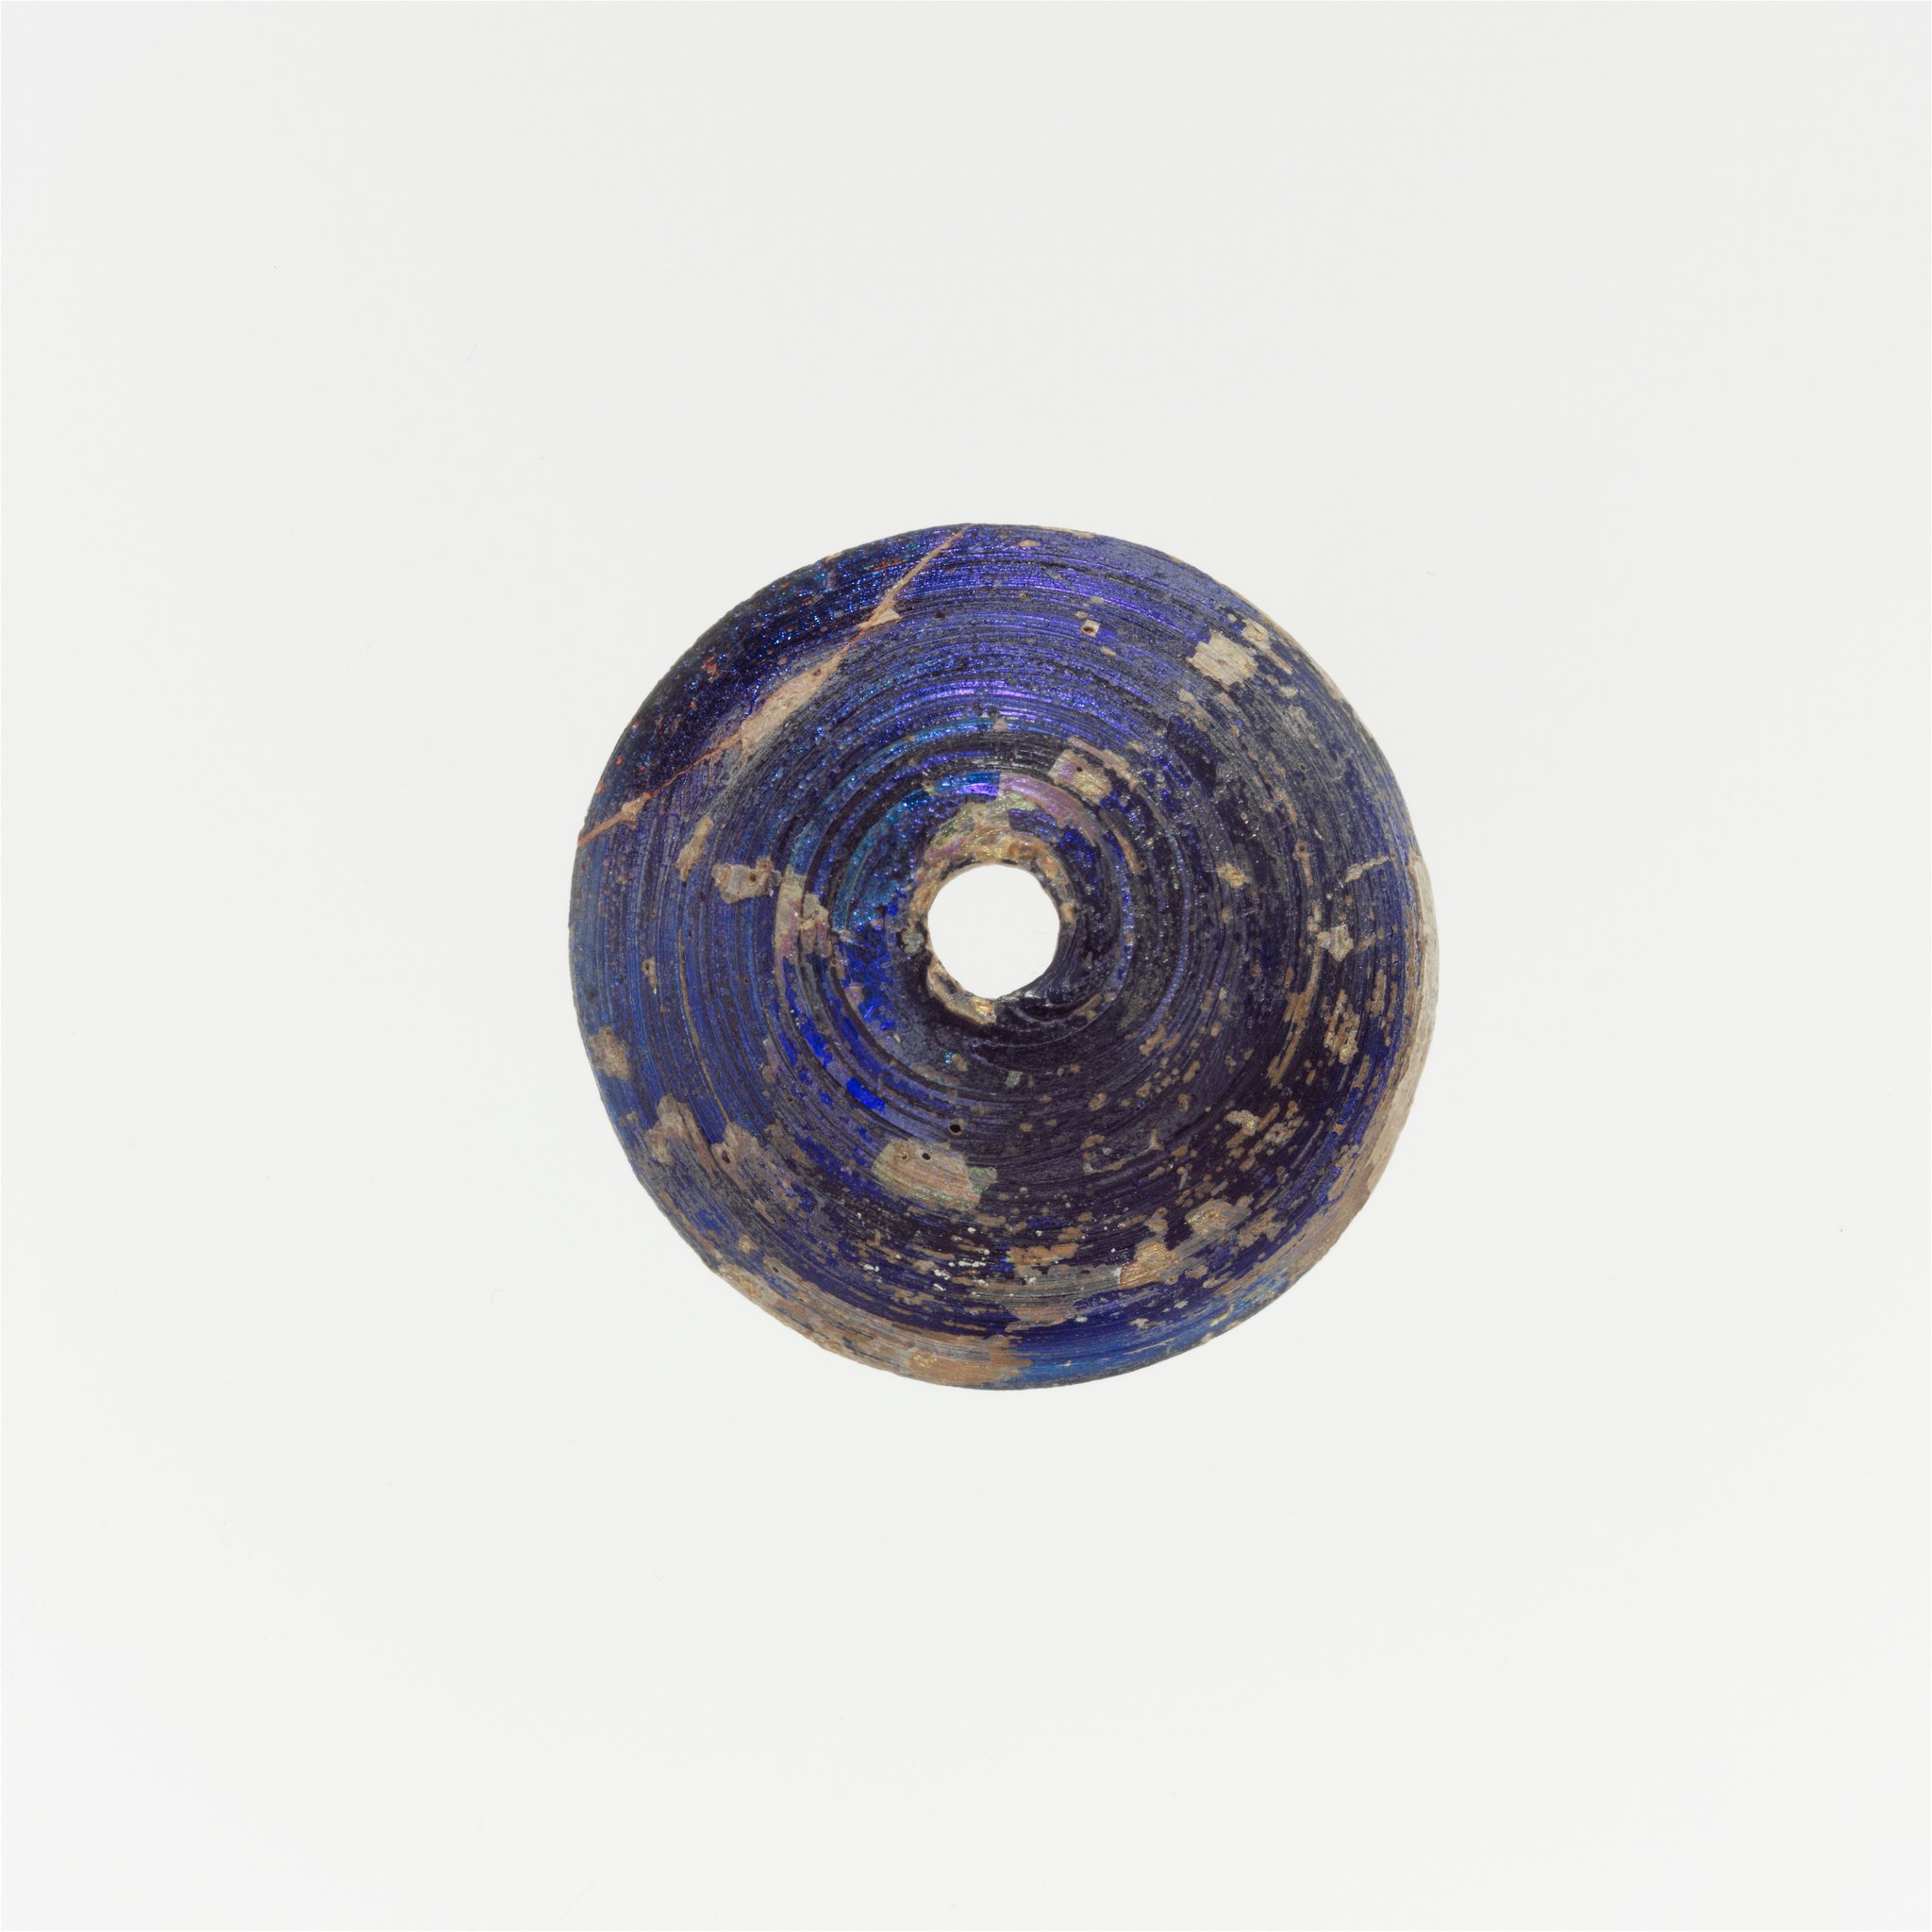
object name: spindle whorl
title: Glass spindle whorl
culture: roman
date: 1-200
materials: glass